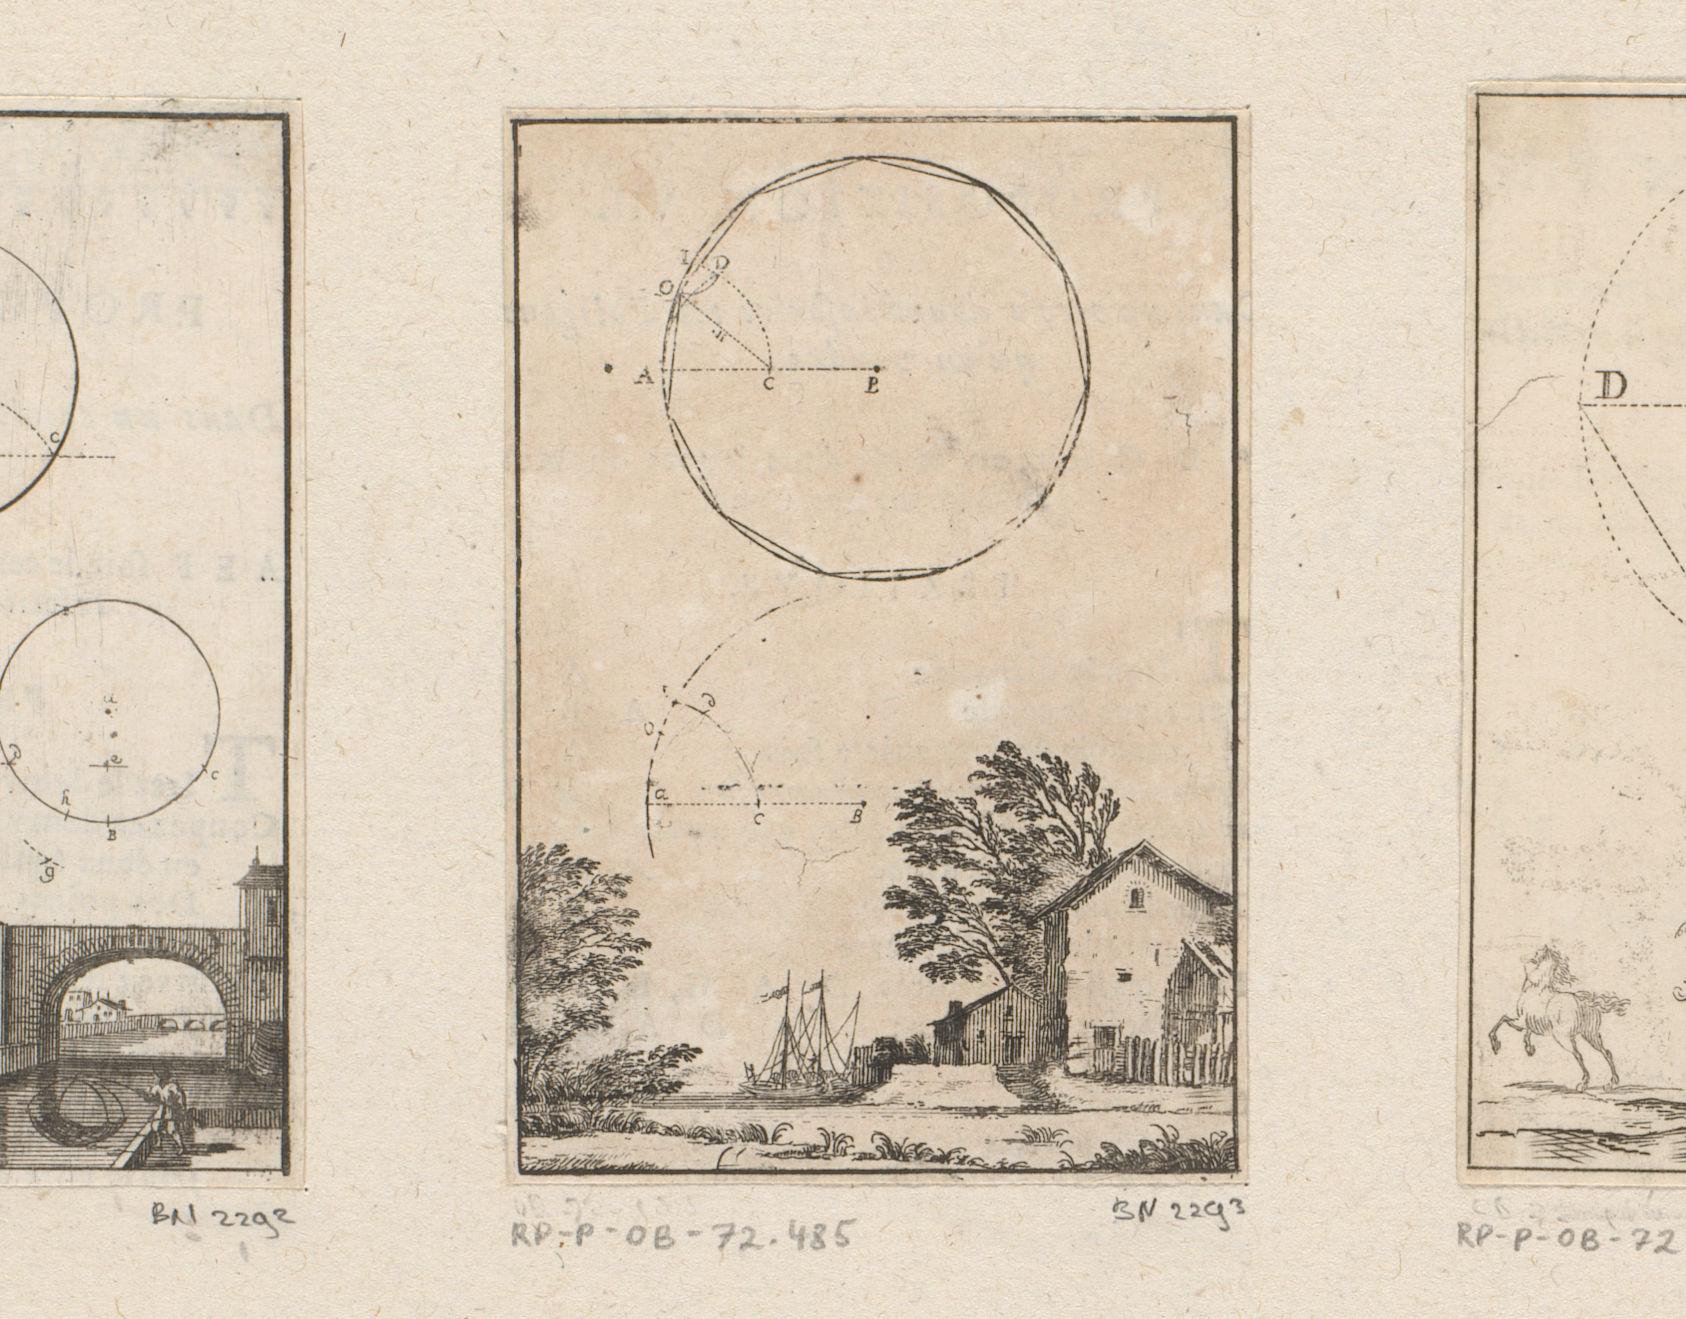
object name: print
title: Constructie van een elfhoek in een cirkel met onderaan een landschap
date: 1669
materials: paper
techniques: etching, letterpress printing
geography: france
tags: landscapes, ships (in general), planimetry, geometry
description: Prent uit: Pratique de la géometrie, sur le papier et sur le terrain. Avec un nouvel ordre et une méthode particulière. Parijs: Thomas Jolly, 1669.